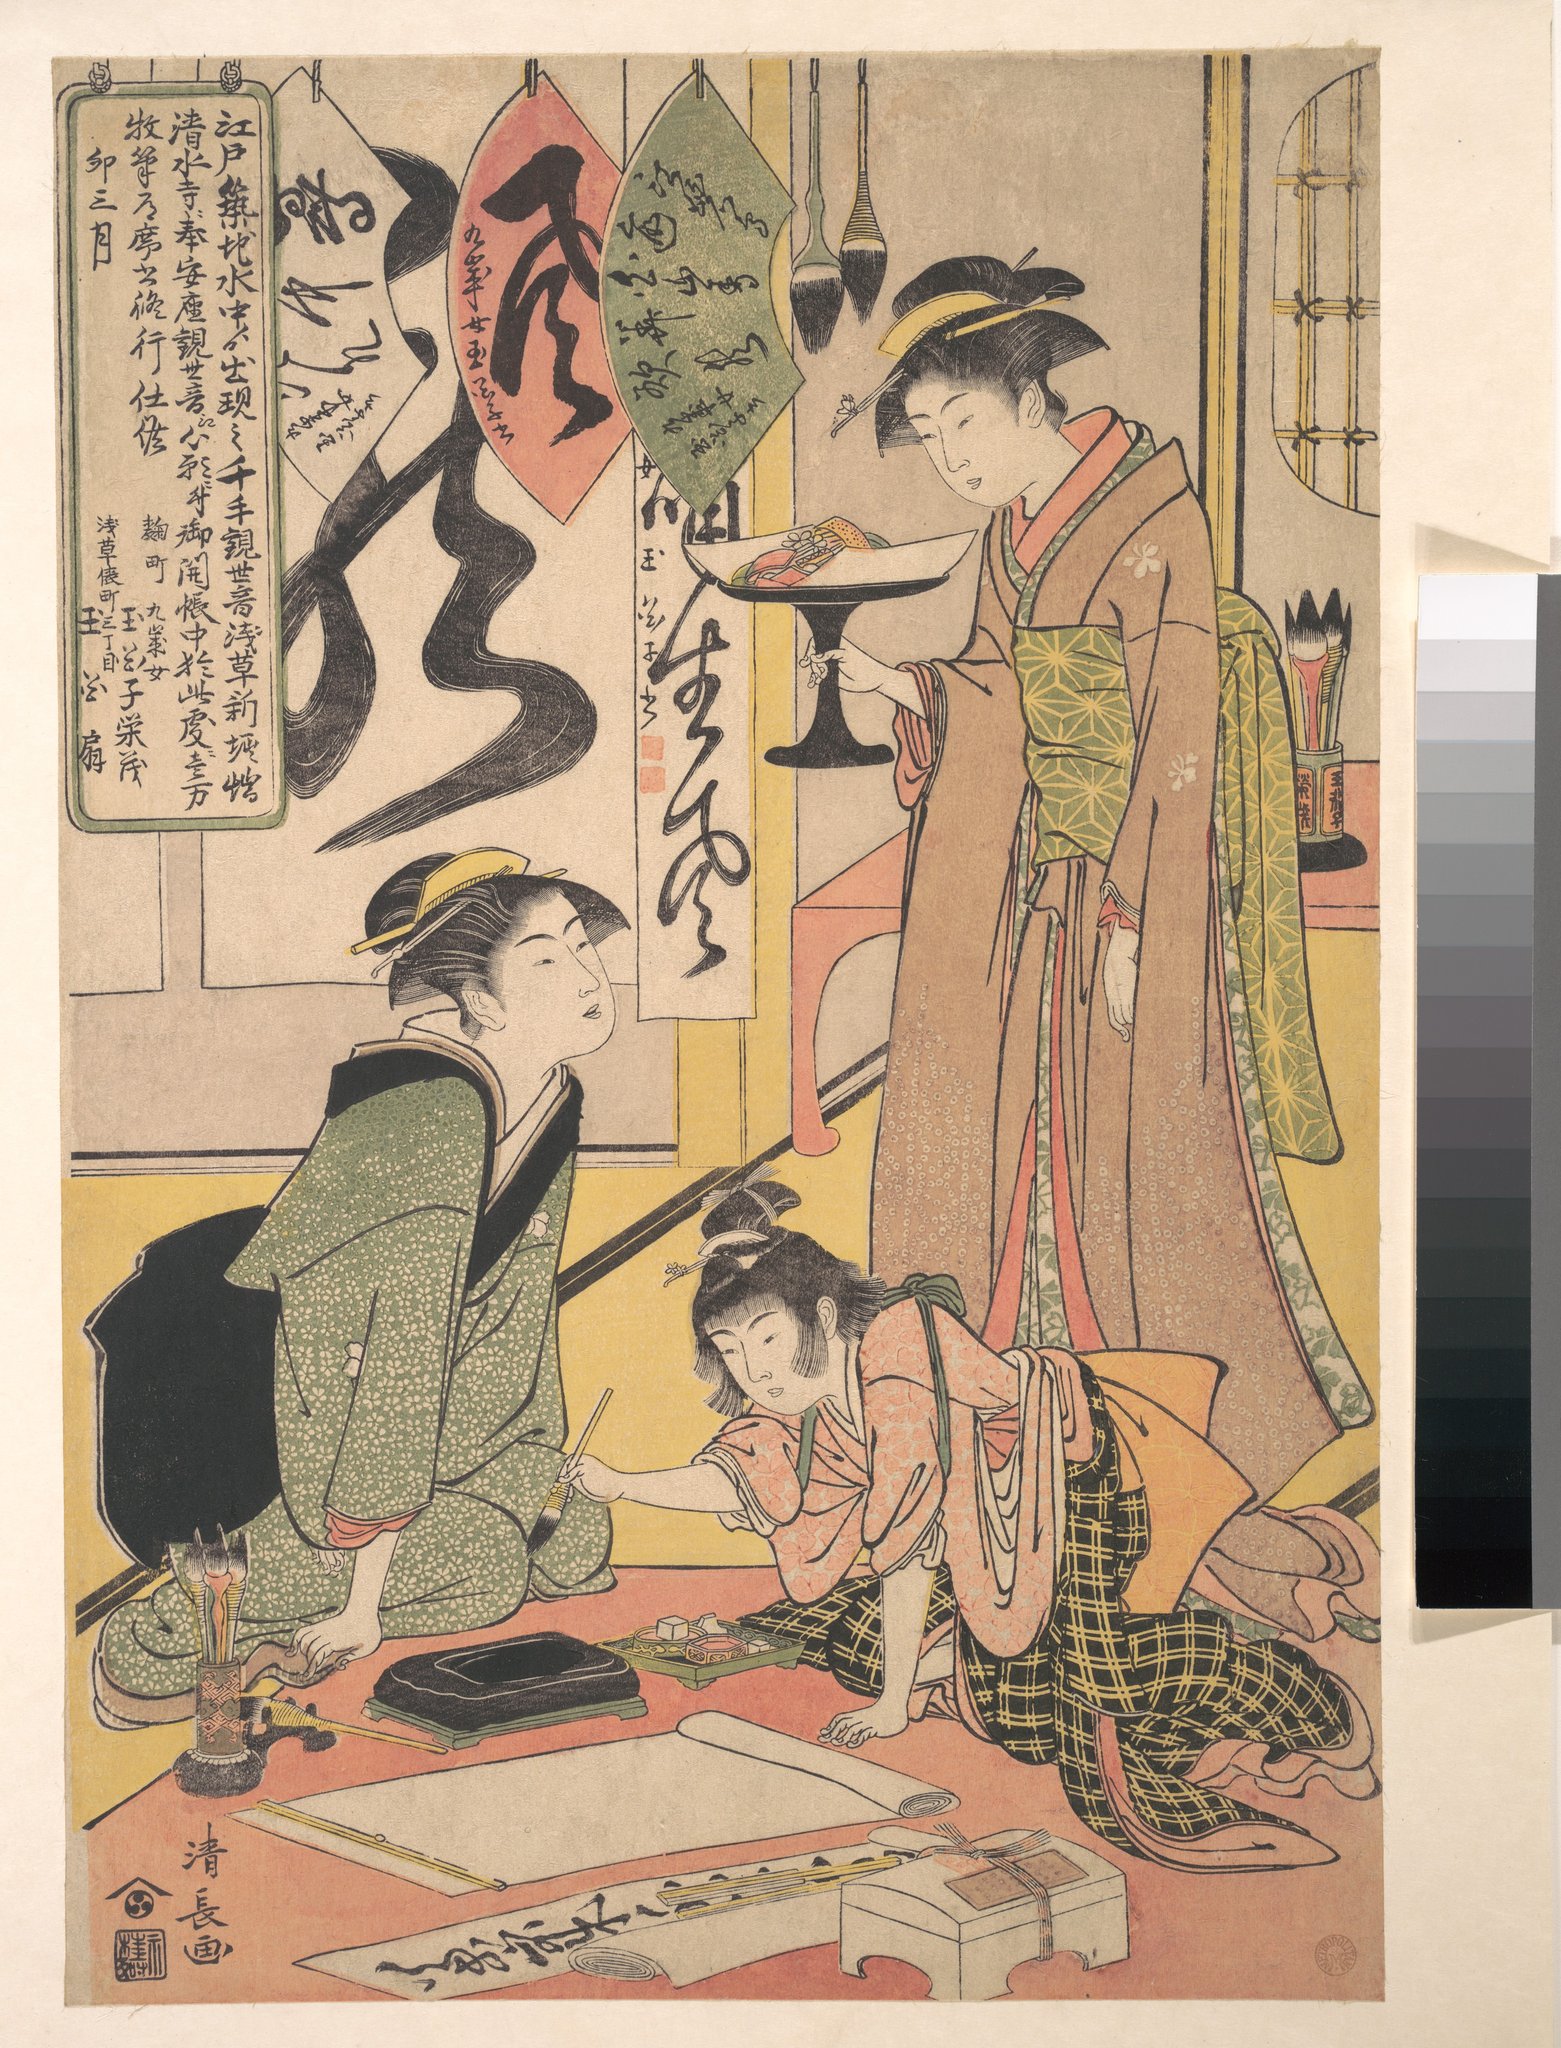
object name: print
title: Gyoku-kashi Eimo Preparing Calligraphy Offerings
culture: japanese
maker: torii kiyonaga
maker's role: artist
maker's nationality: japanese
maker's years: 1752-1815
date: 1782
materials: ink, paper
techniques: woodblock print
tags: girls,women,writing,calligraphy